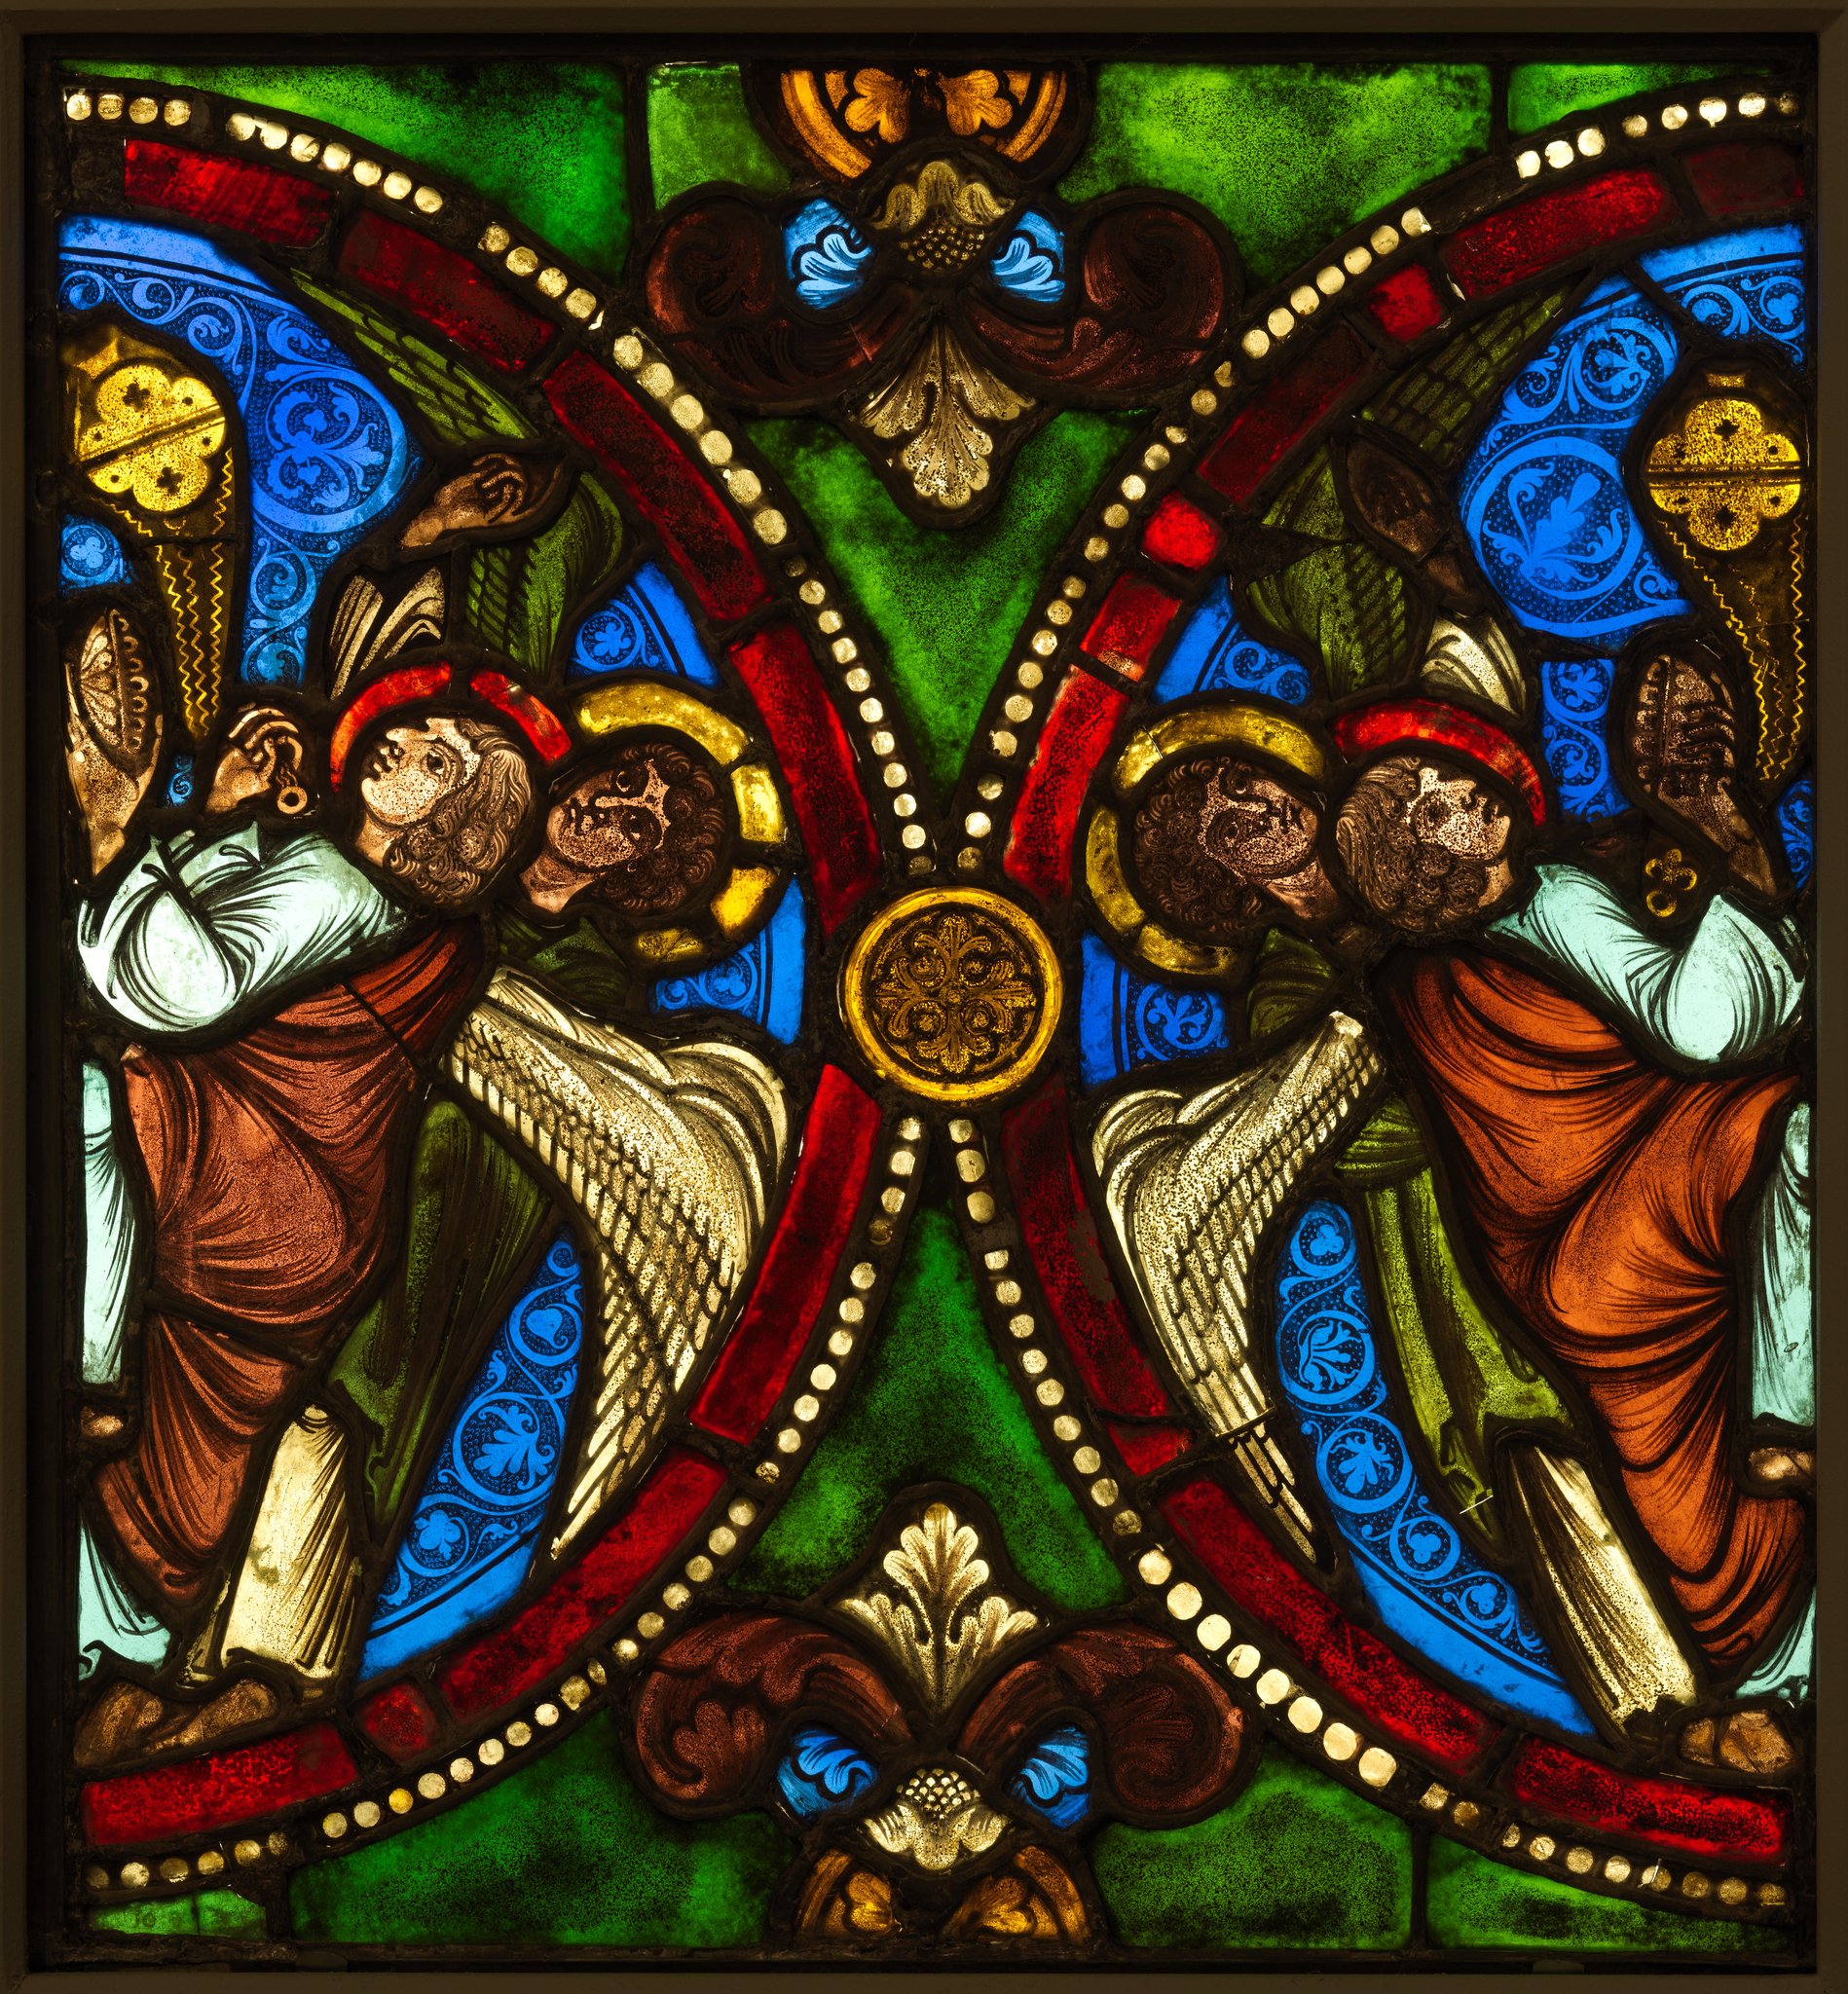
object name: panel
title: Angels Swinging Censers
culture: french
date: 1170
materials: glass, lead, metal, paint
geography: troyes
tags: angels,censers